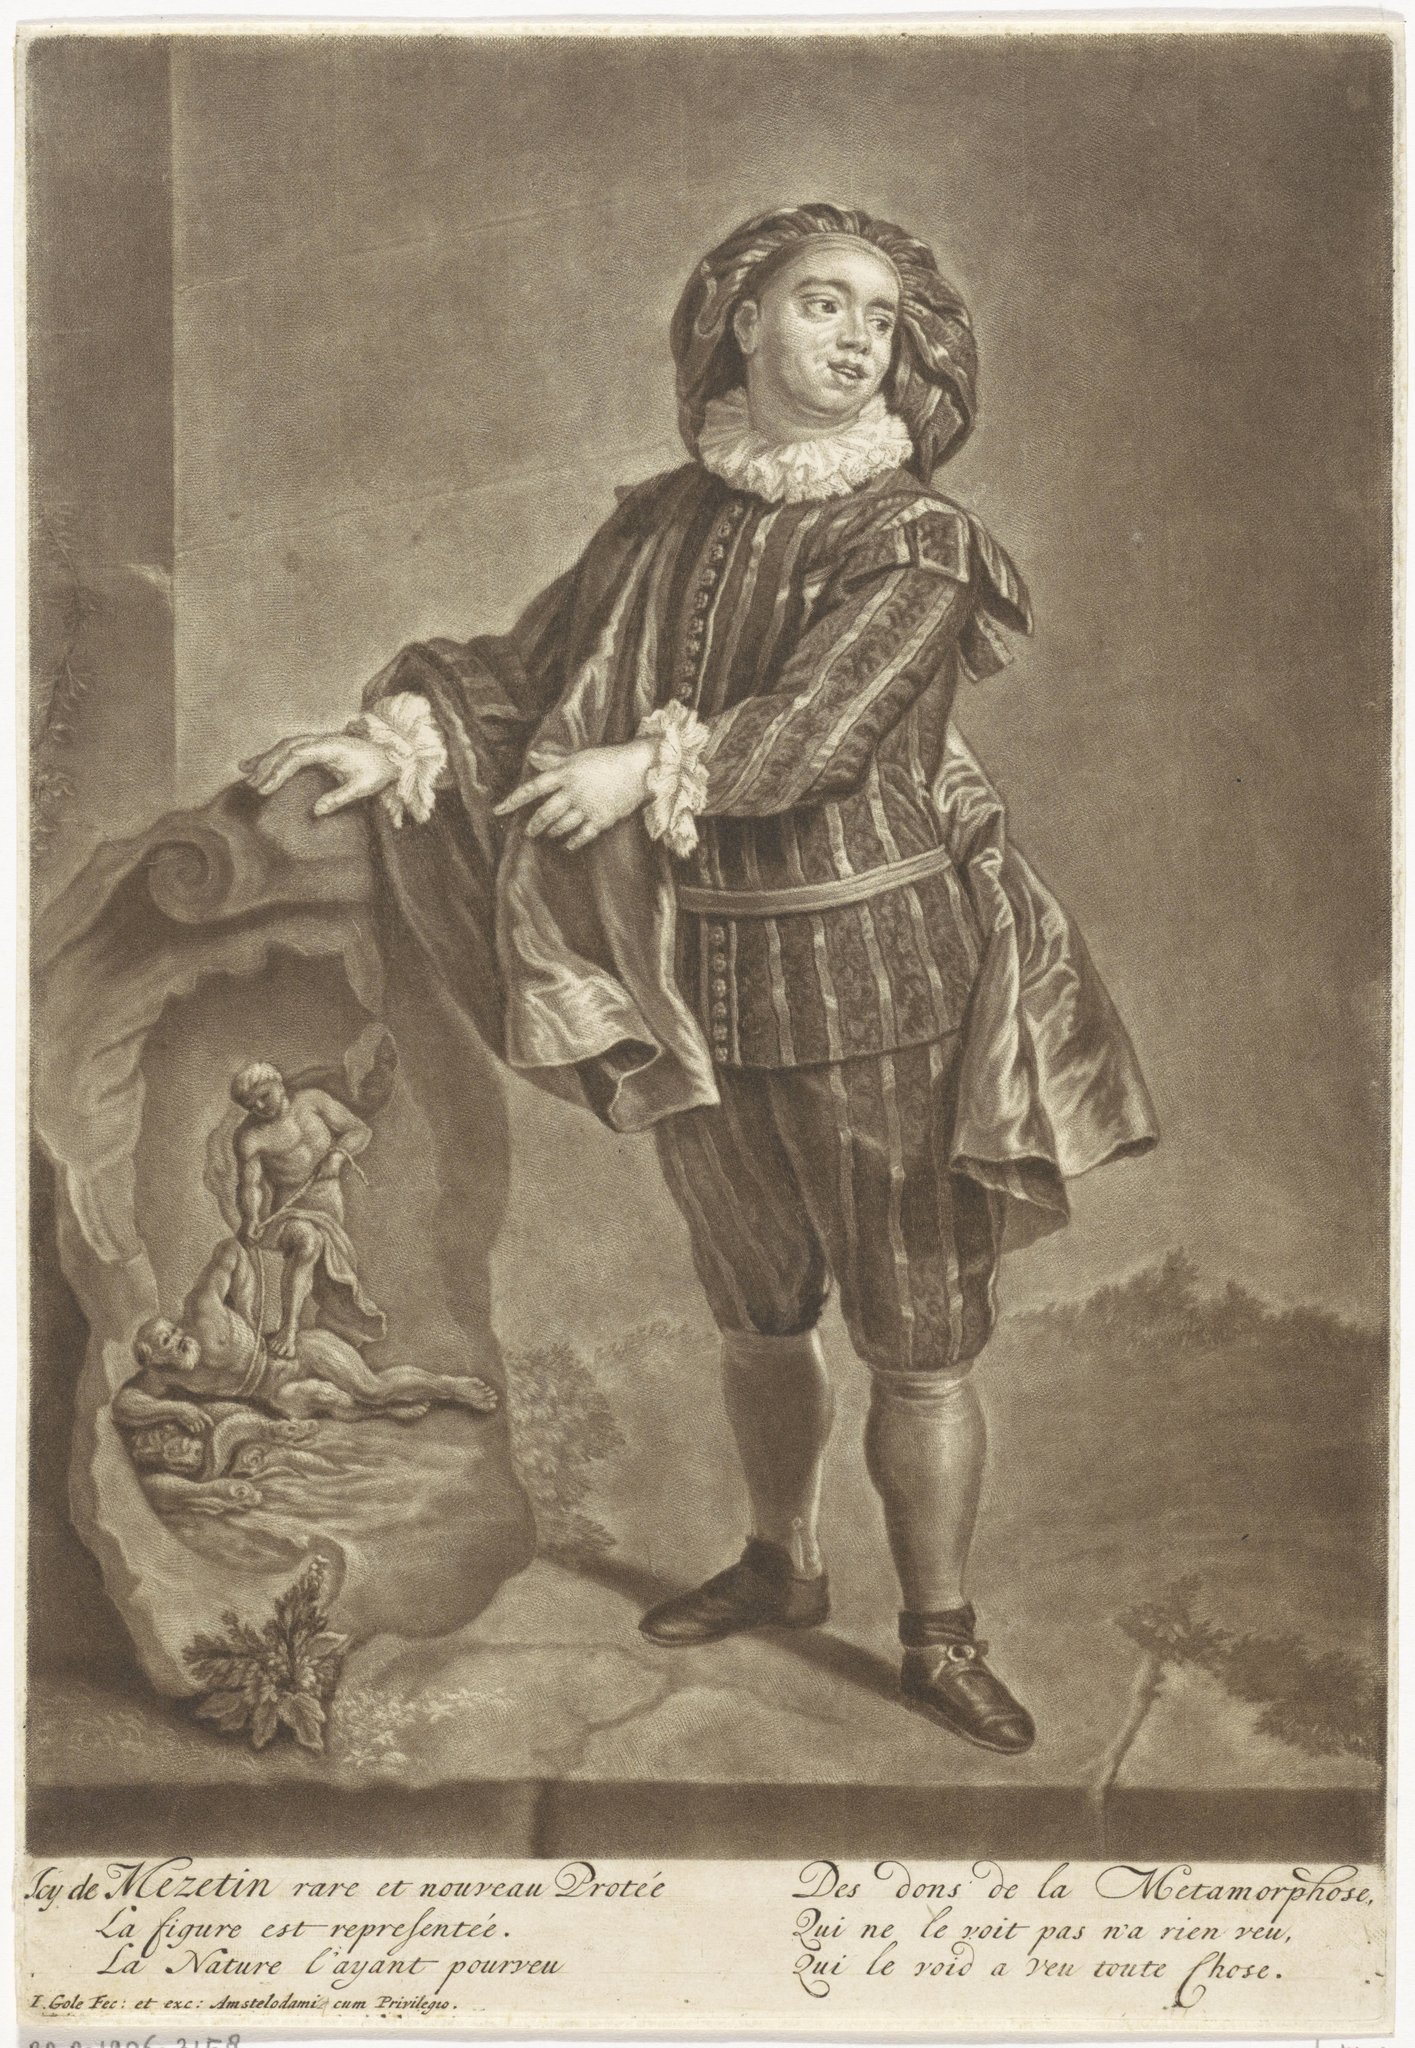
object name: print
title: Portret van Angelo Constantini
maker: jacob gole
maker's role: print maker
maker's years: 1660-1724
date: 1670-1724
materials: paper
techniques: engraving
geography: amsterdam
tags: portrait of actor, actress, historical persons (portraits and scenes from the life) (+ all kinds of 'portrait historié': mythological portrait, allegorical portrait, 'rollenporträt', etc.)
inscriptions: collector's mark: Lugt 2228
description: Portret van de Italiaanse acteur Angelo Constantini in de rol van Mezzetino (of Mezzettino). Hij wijst op een reliëf.